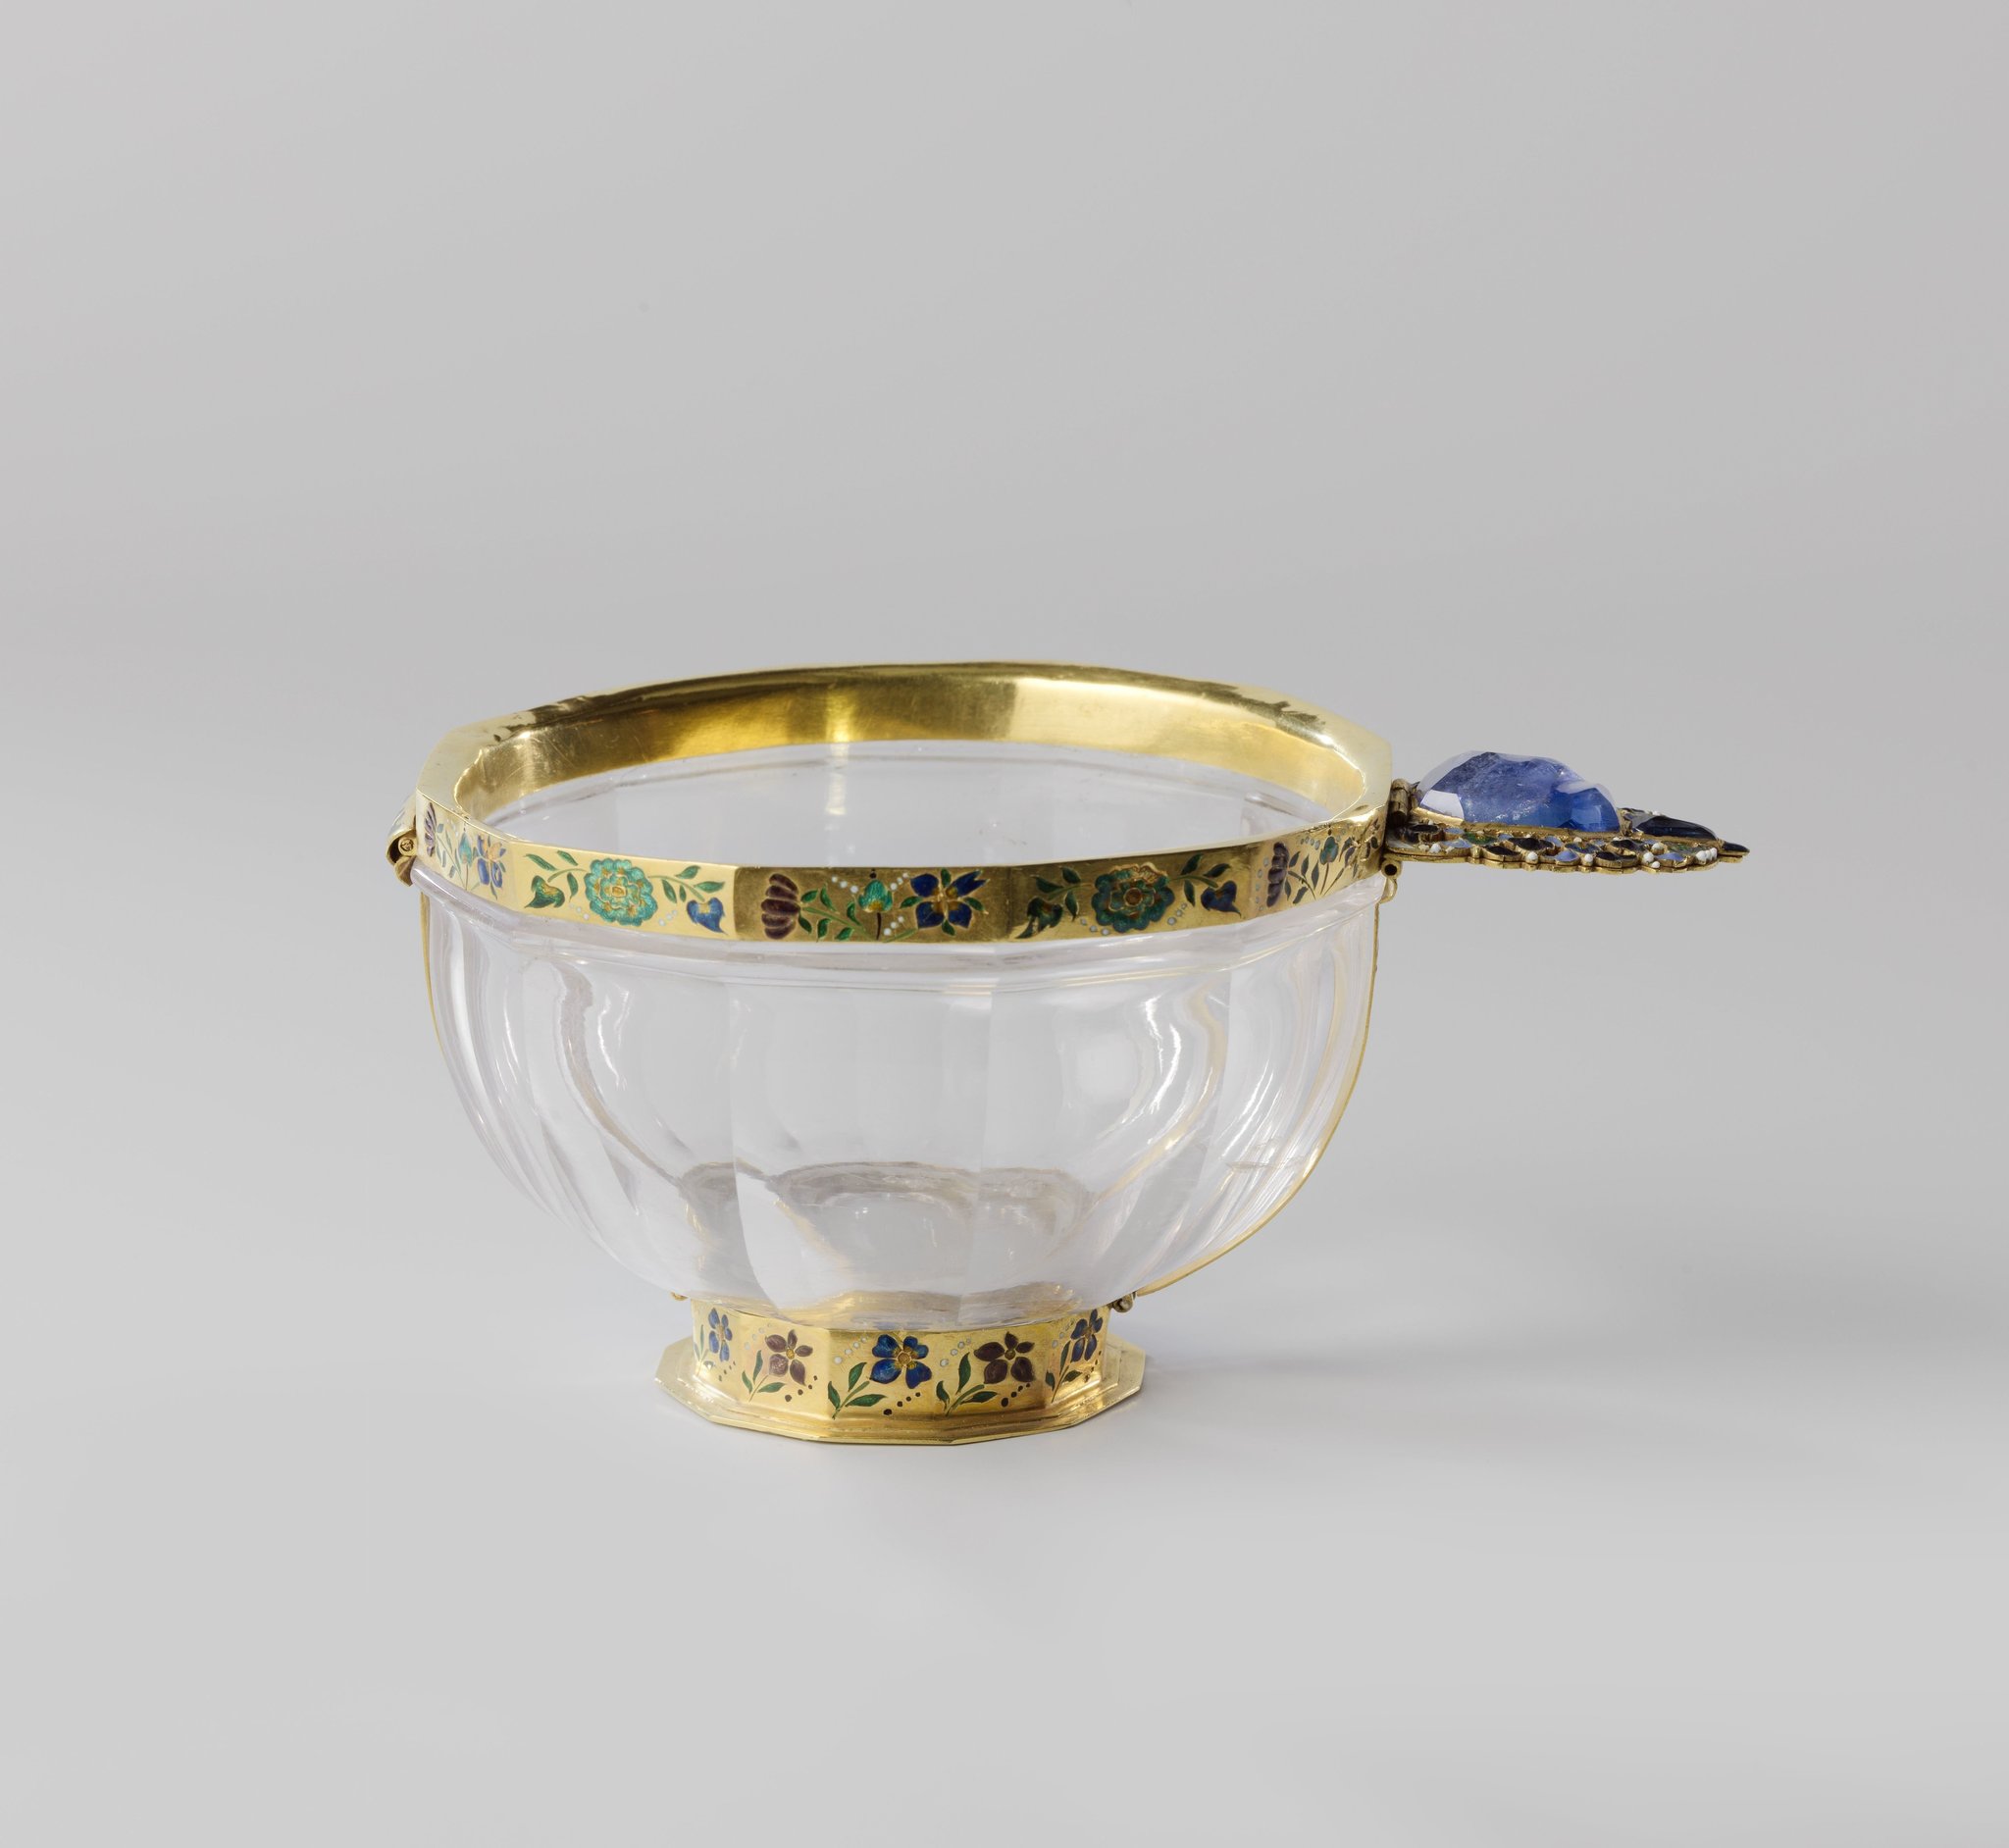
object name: vessel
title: Coupe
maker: Anonymous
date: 1400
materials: gold, gemstone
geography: eastern europe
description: Fashioned by a goldsmith, the mount of this cup immediately catches the eye. The pattern of flowers and birds was first chased in gold, and then filled with glass powder and fired. Given the different melting point of each colour of glass, the process must have been repeated at least seven times. The handle was subsequently set with gemstones.